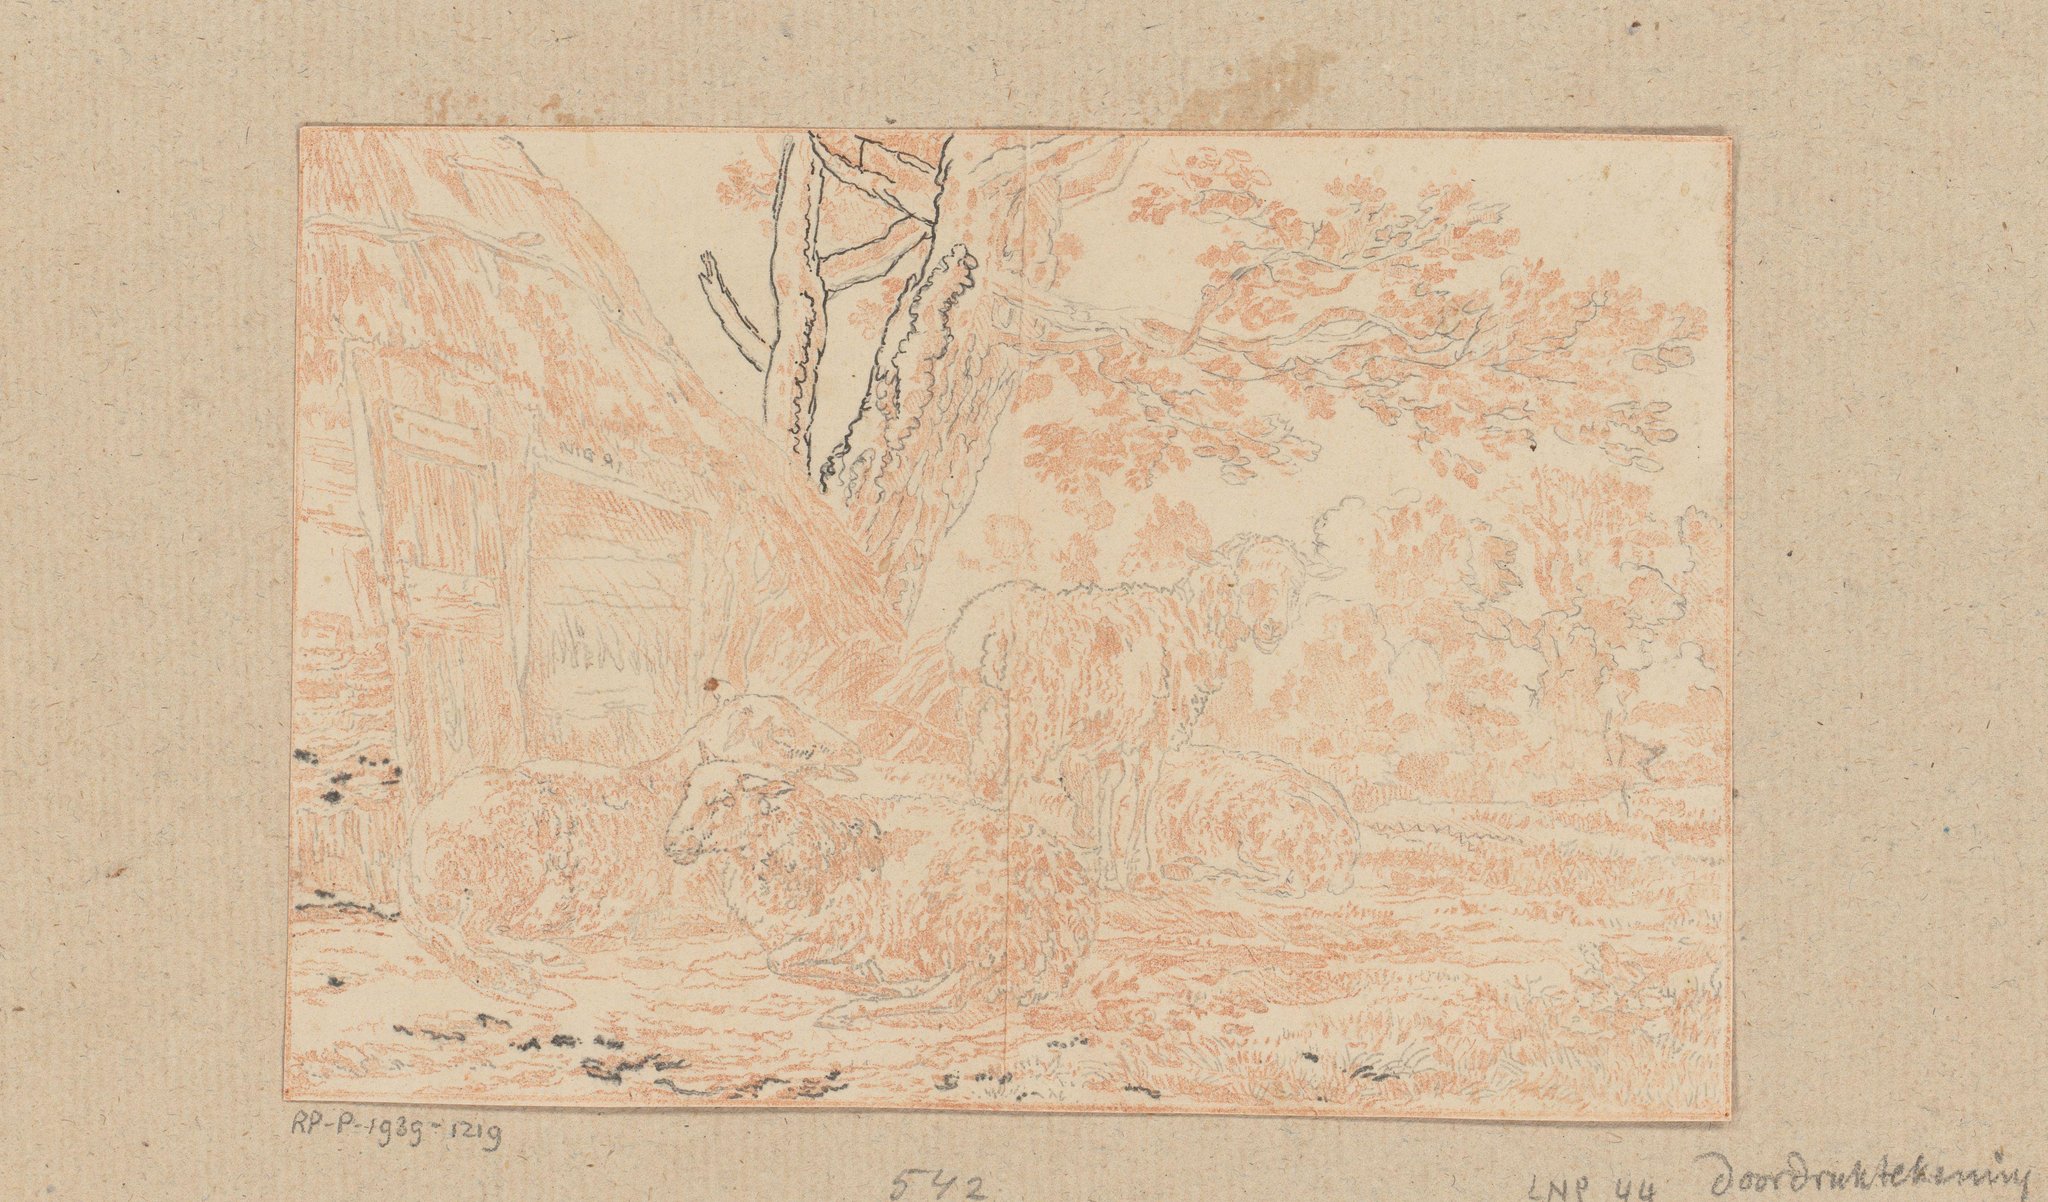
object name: drawing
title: Schaapskooi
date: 1781-1787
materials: chalk, ink, paper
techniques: brush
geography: amsterdam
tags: sheep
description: Vier schapen bij de geopende schaapskooi. De doordruktekening ligt los in een album, zie blad 44.